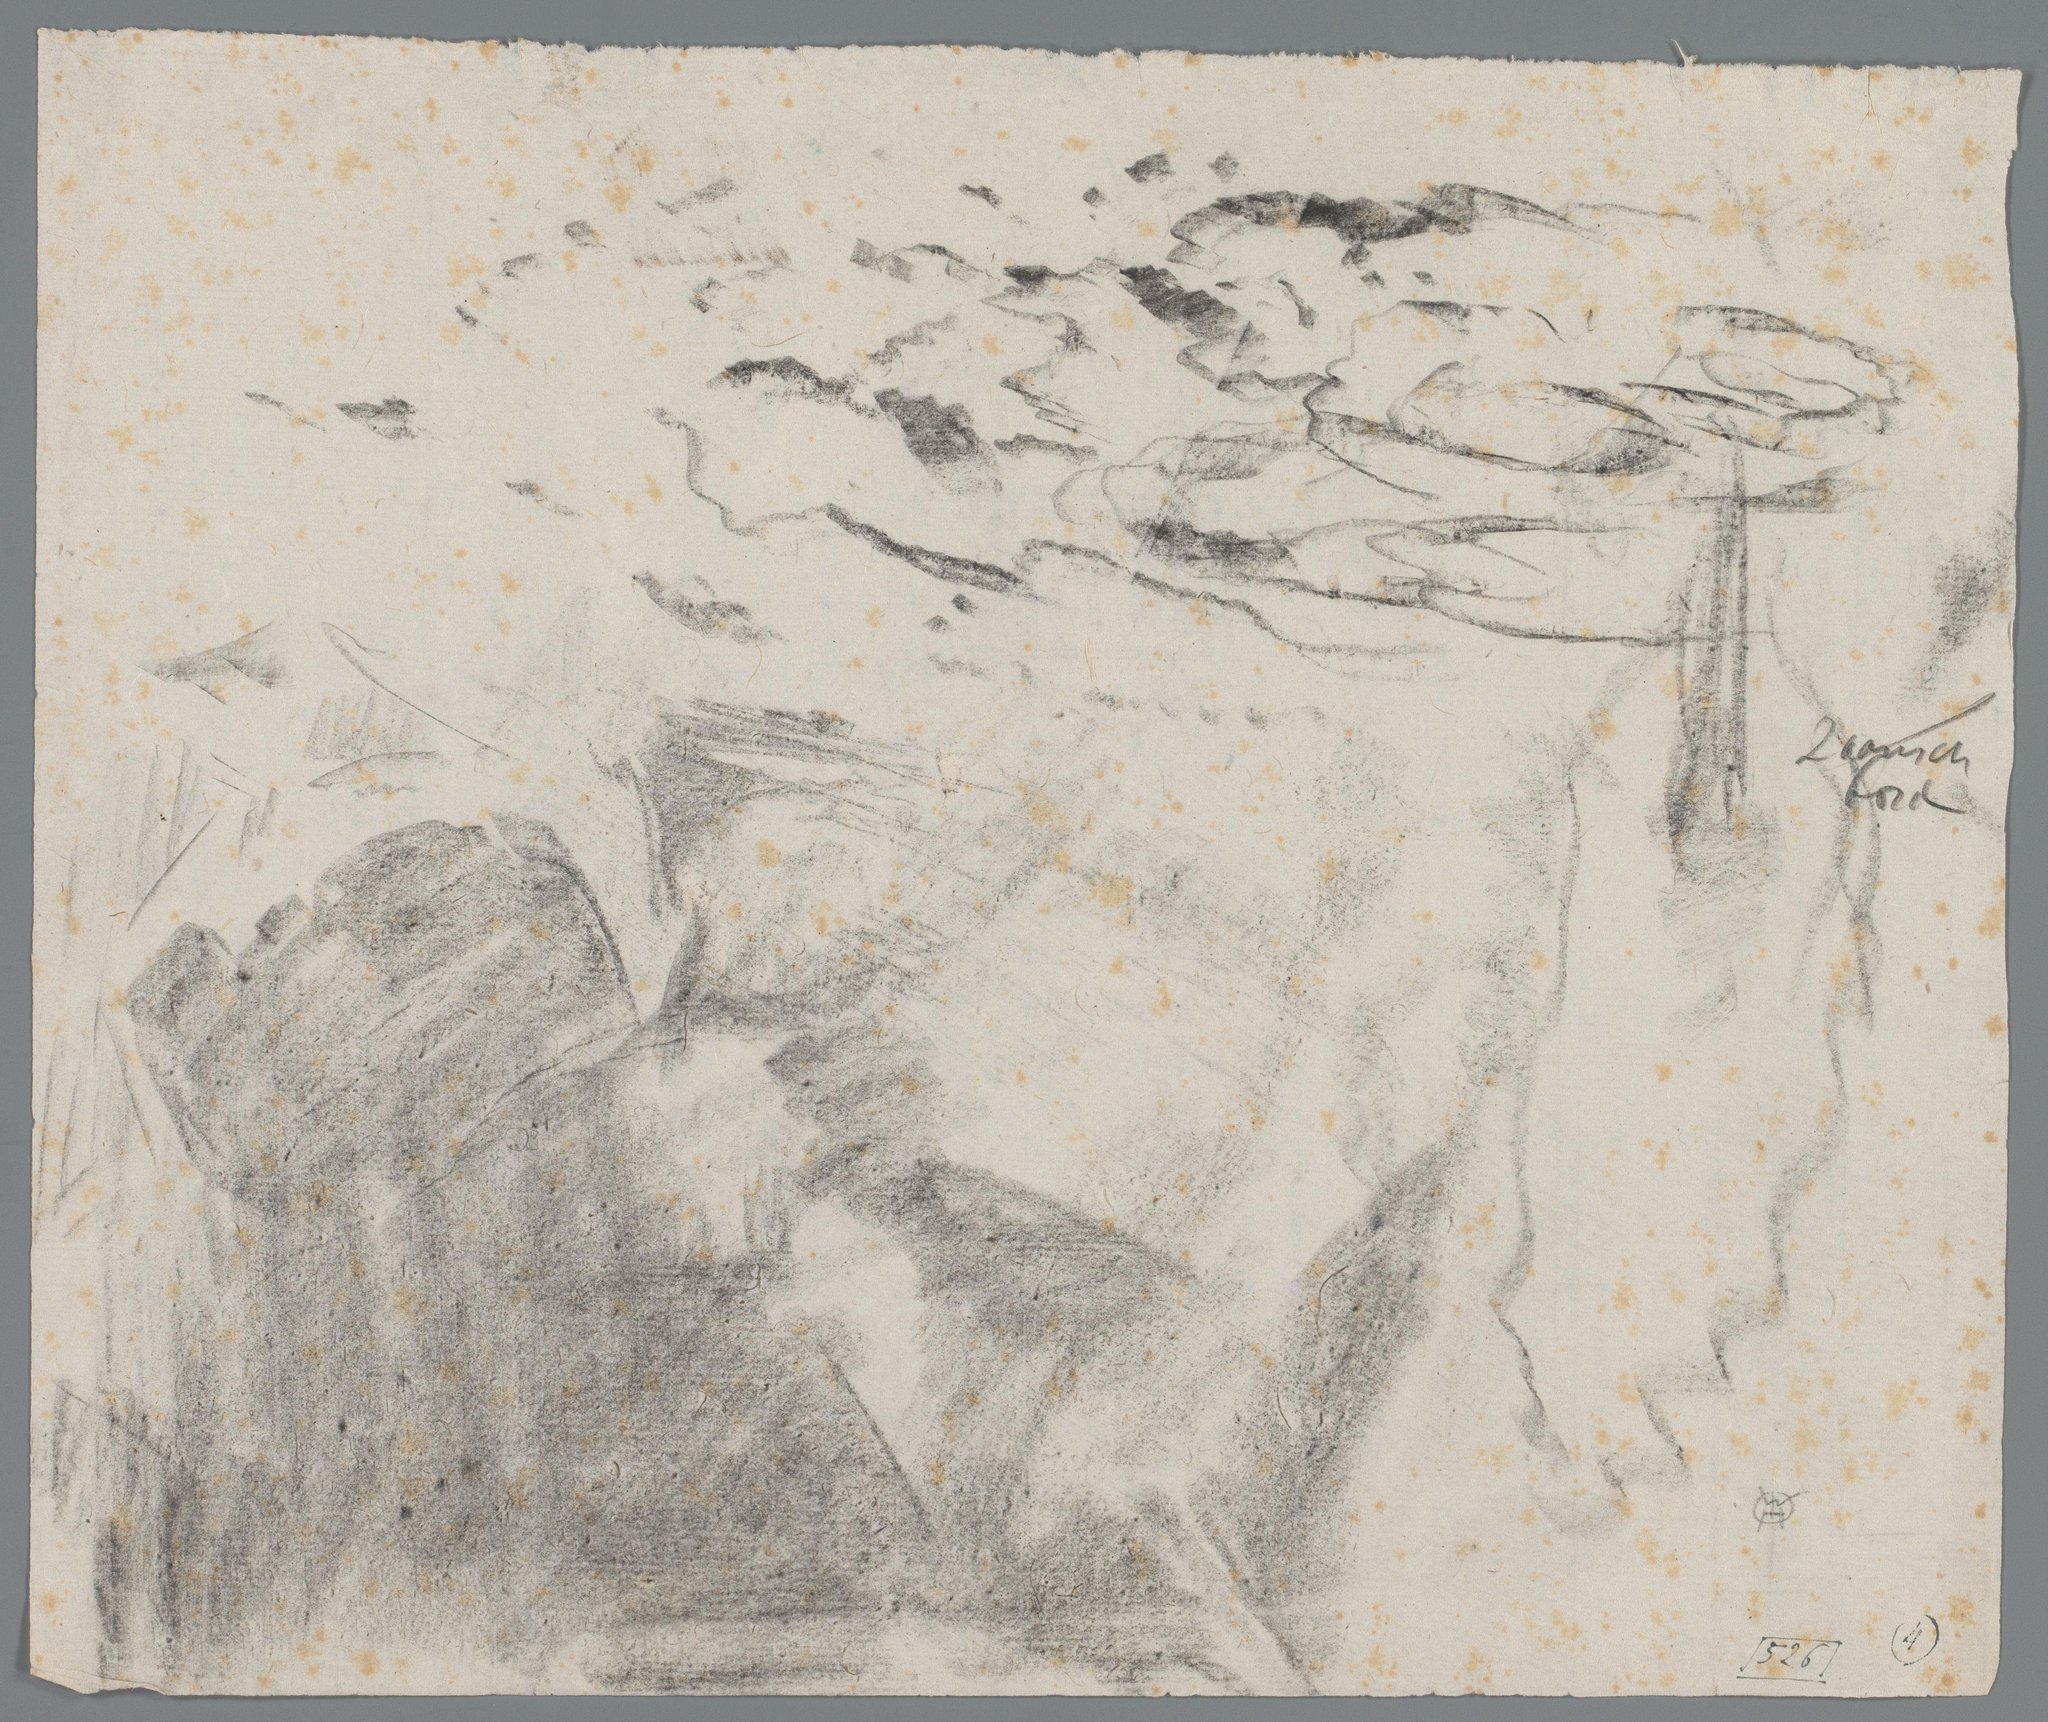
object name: drawing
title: Schets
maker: gerrit willem dijsselhof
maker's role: designer, draughtsman, print maker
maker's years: 1866-1924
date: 1876-1924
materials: chalk, paper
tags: aquarium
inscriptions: number: ‘526’, number: ‘4’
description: Mogelijk een studie van een aquarium. Met een aantekening.